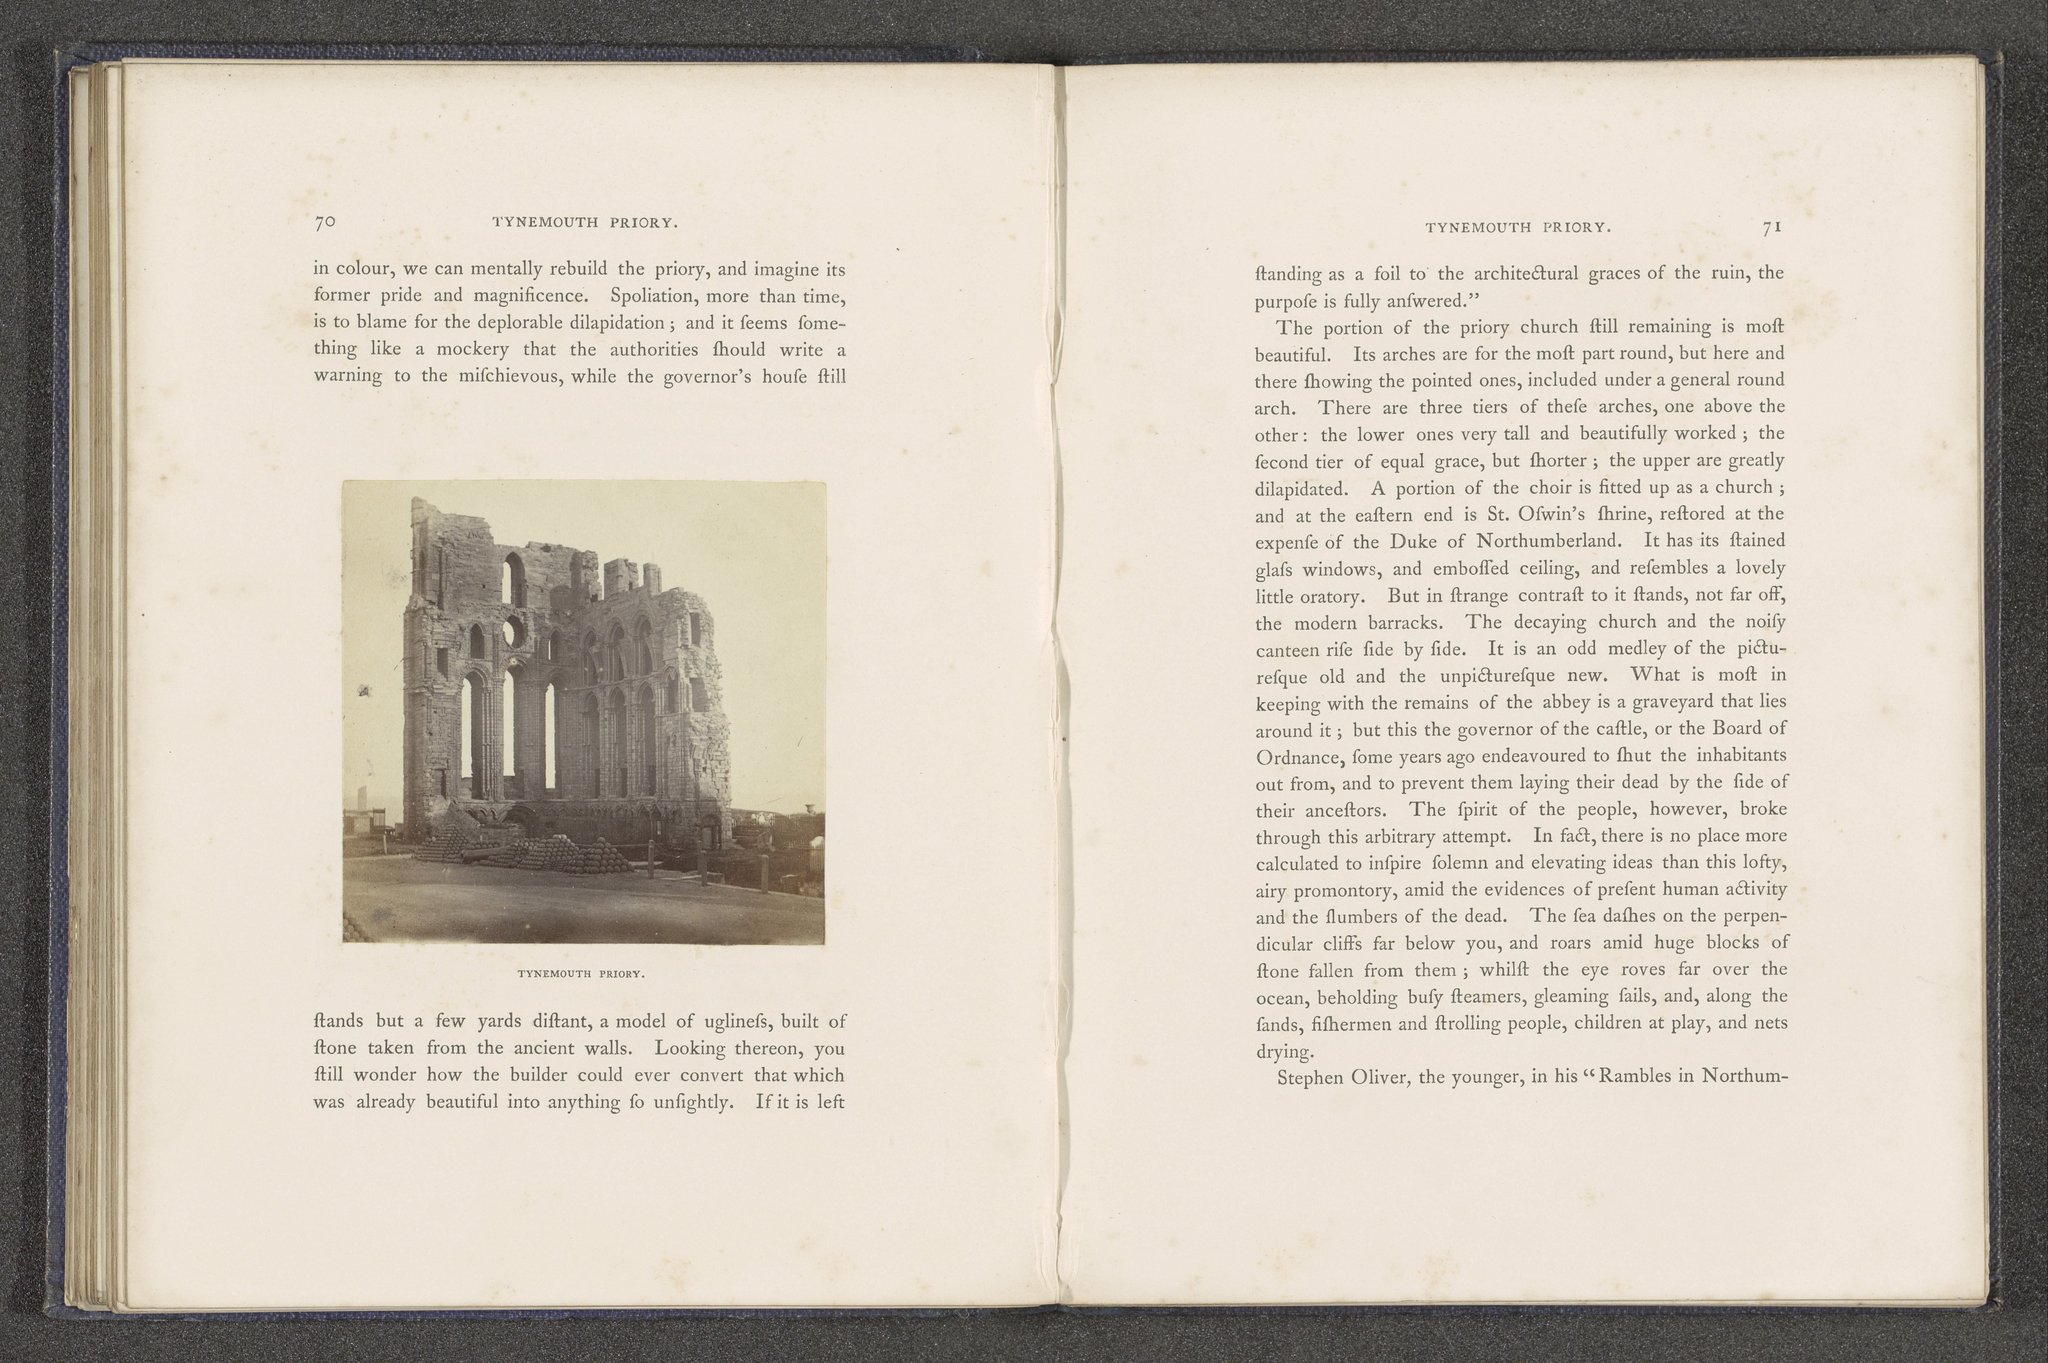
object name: photograph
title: Tynemouth Priory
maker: stephen thompson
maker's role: fotograaf, schrijver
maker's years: 1831-1893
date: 1854-1864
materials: photographic support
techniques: albumen print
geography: tynemouth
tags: ruin of church, monastery, etc.